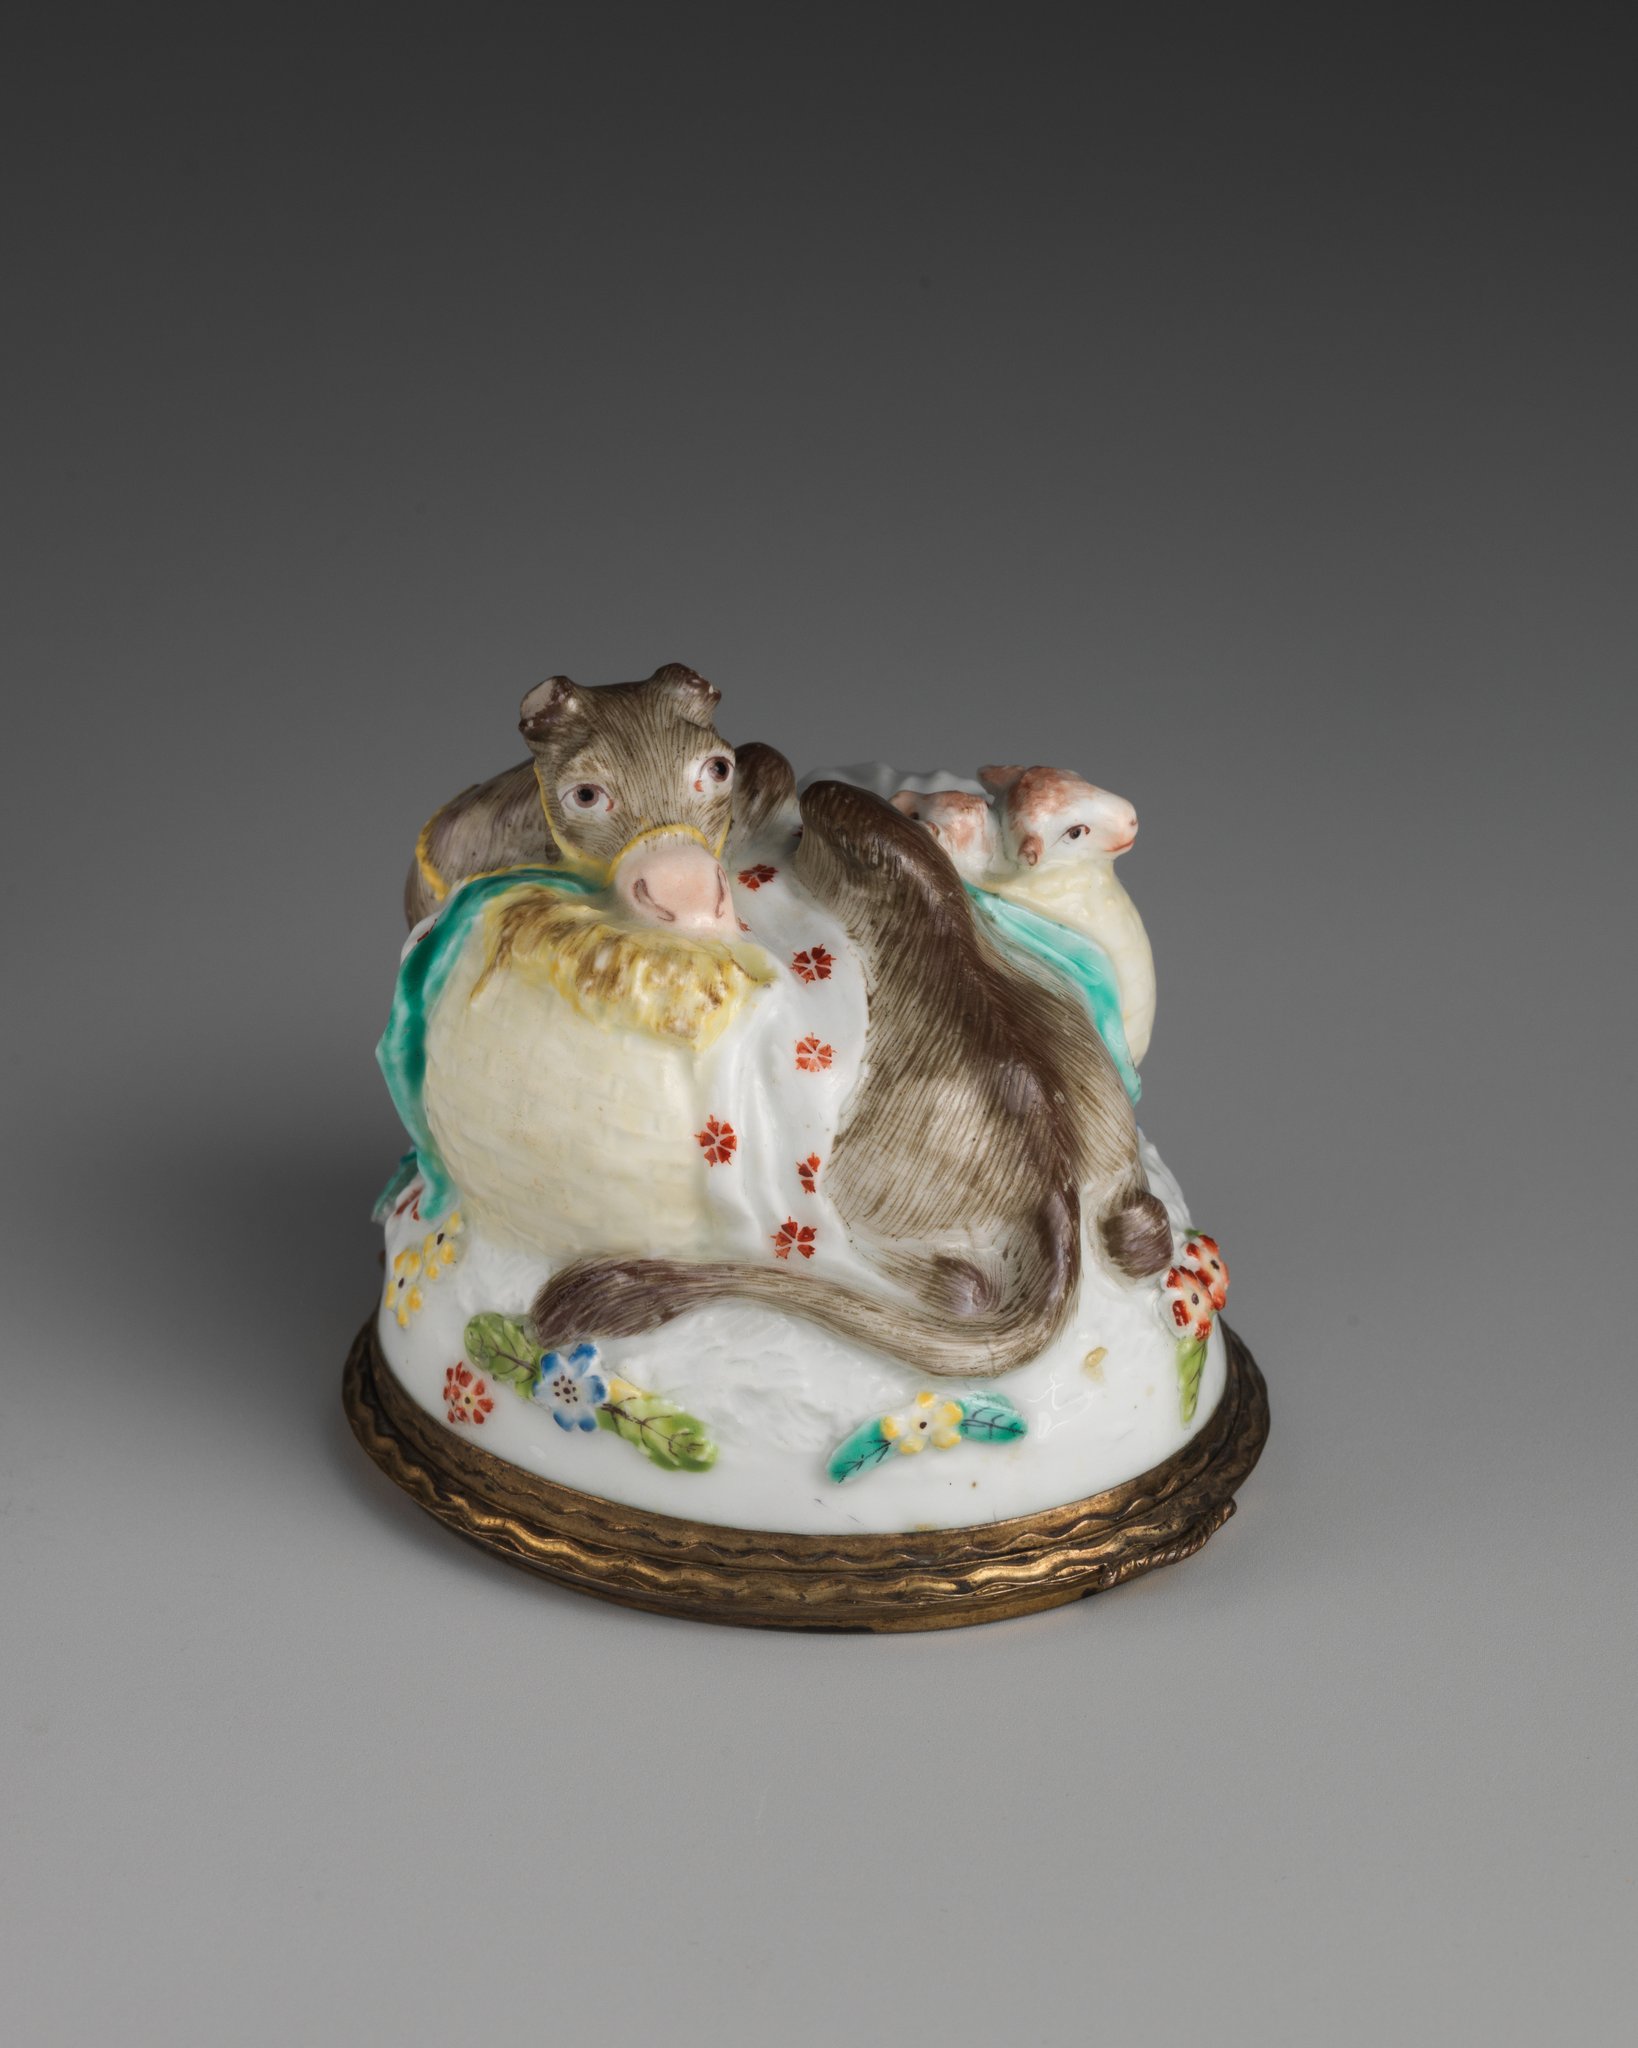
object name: toy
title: Camel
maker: chelsea porcelain manufactory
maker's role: factory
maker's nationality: british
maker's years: 1744-1784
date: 1760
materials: soft paste porcelain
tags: animals,camels